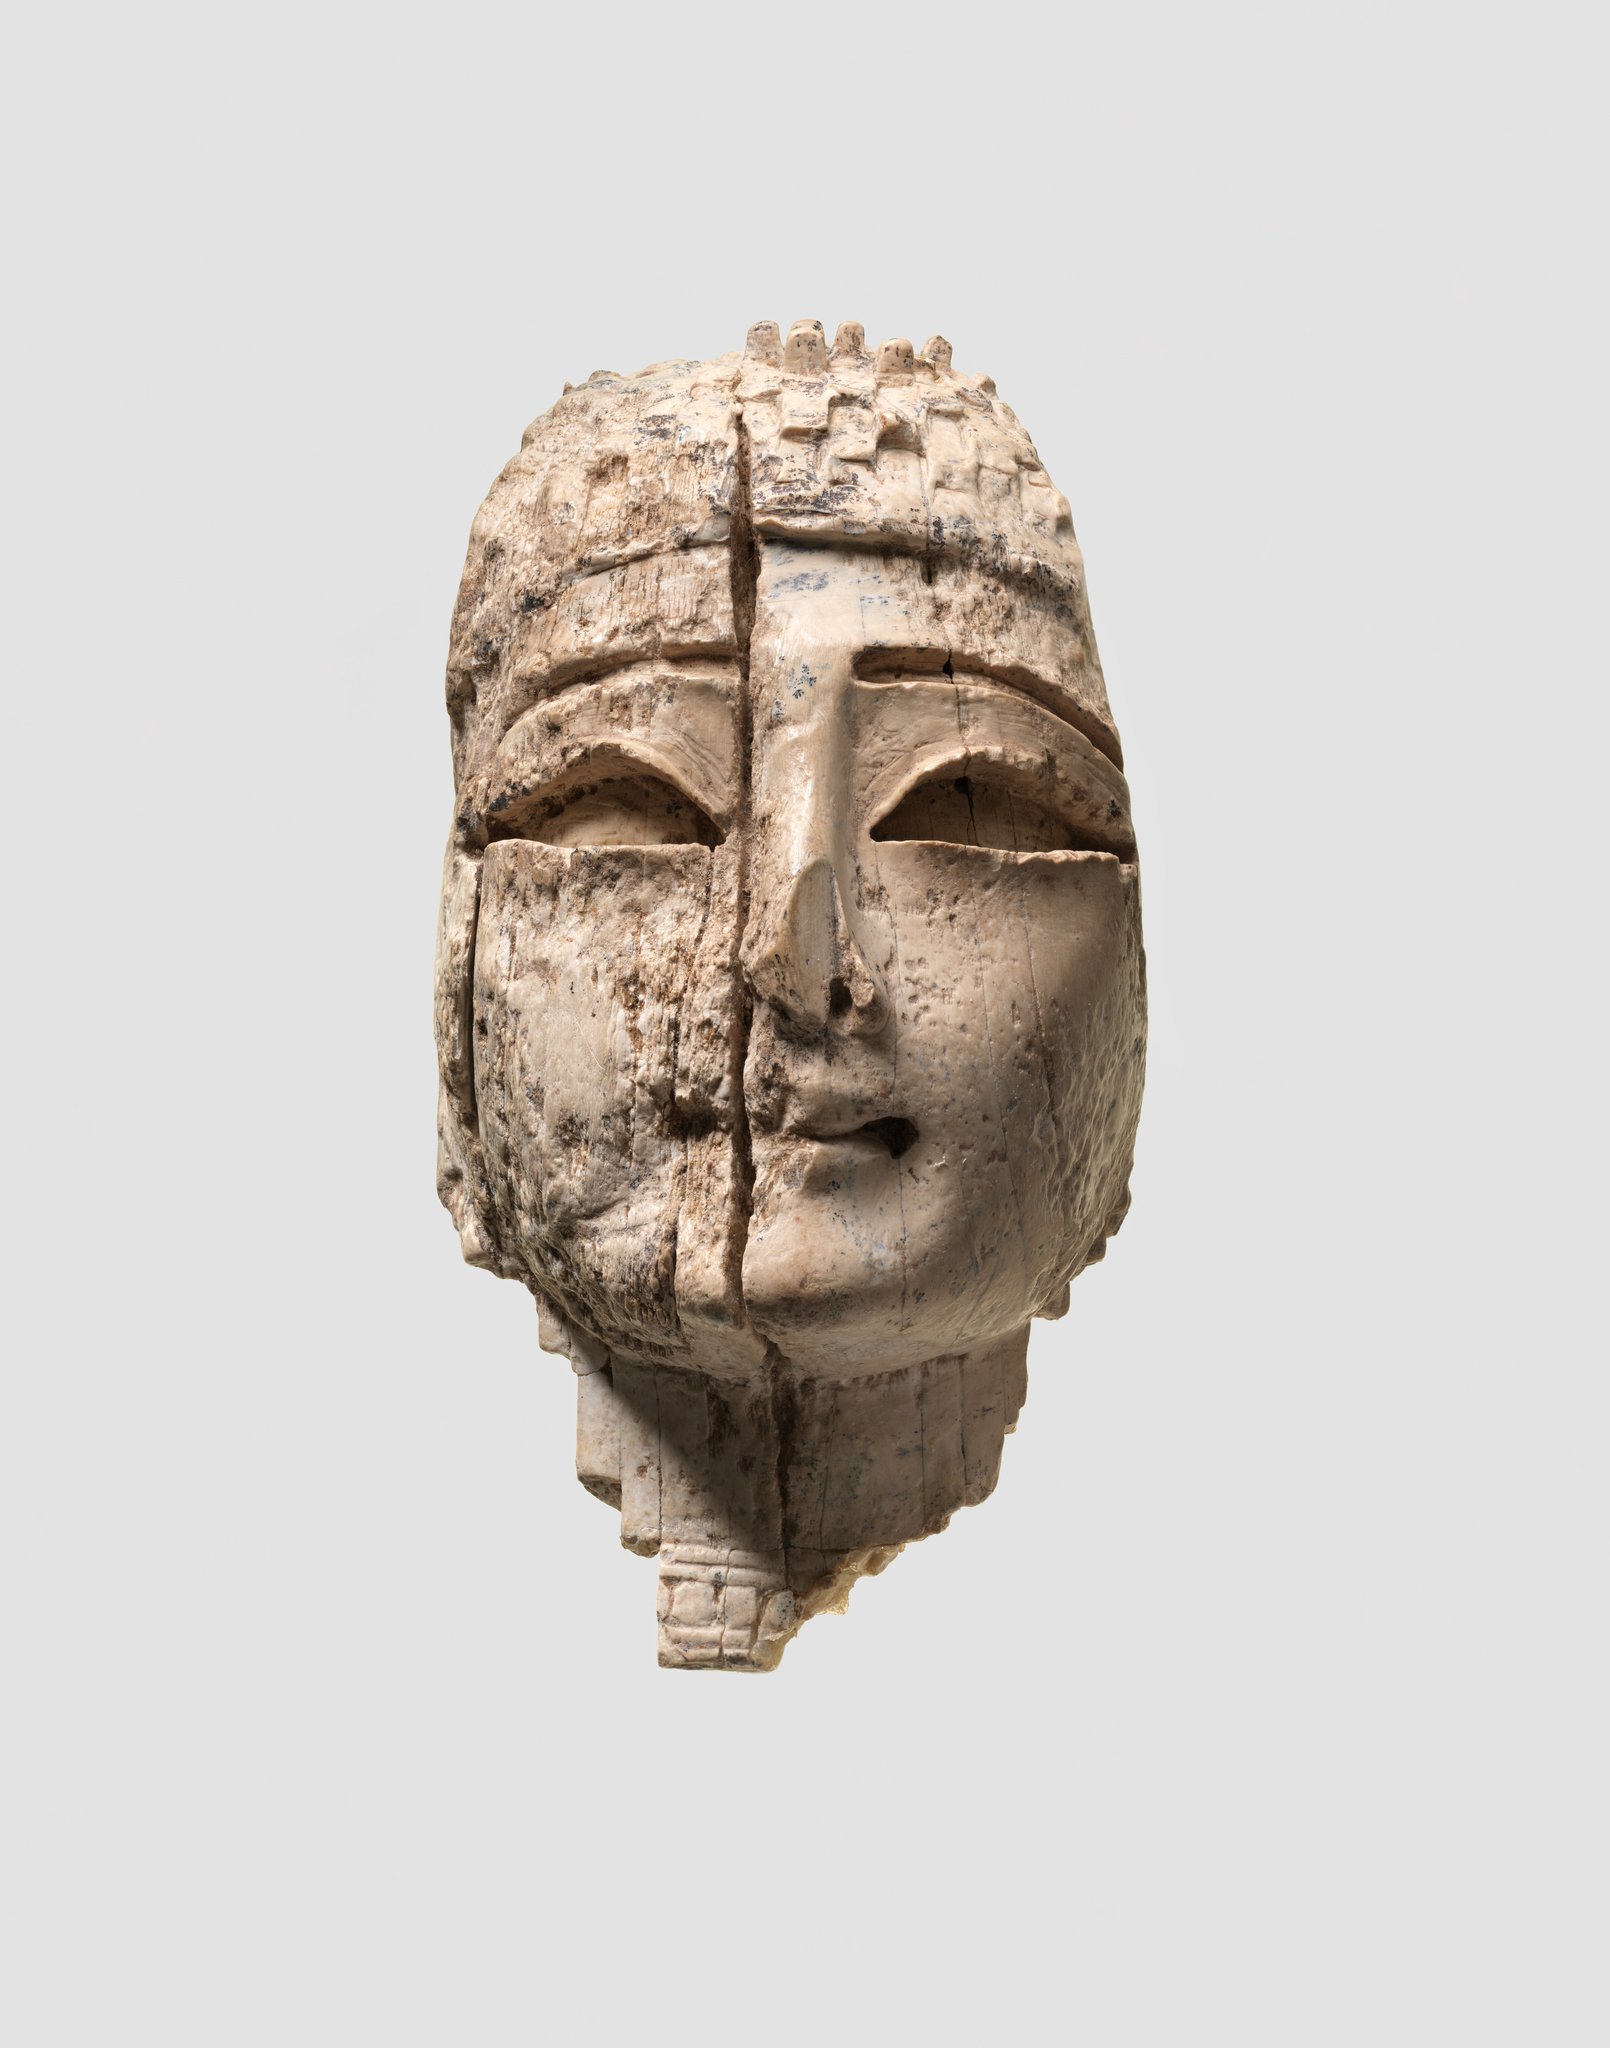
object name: sculpture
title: Female head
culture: assyrian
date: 800-601 BCE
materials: ivory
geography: mesopotamia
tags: women